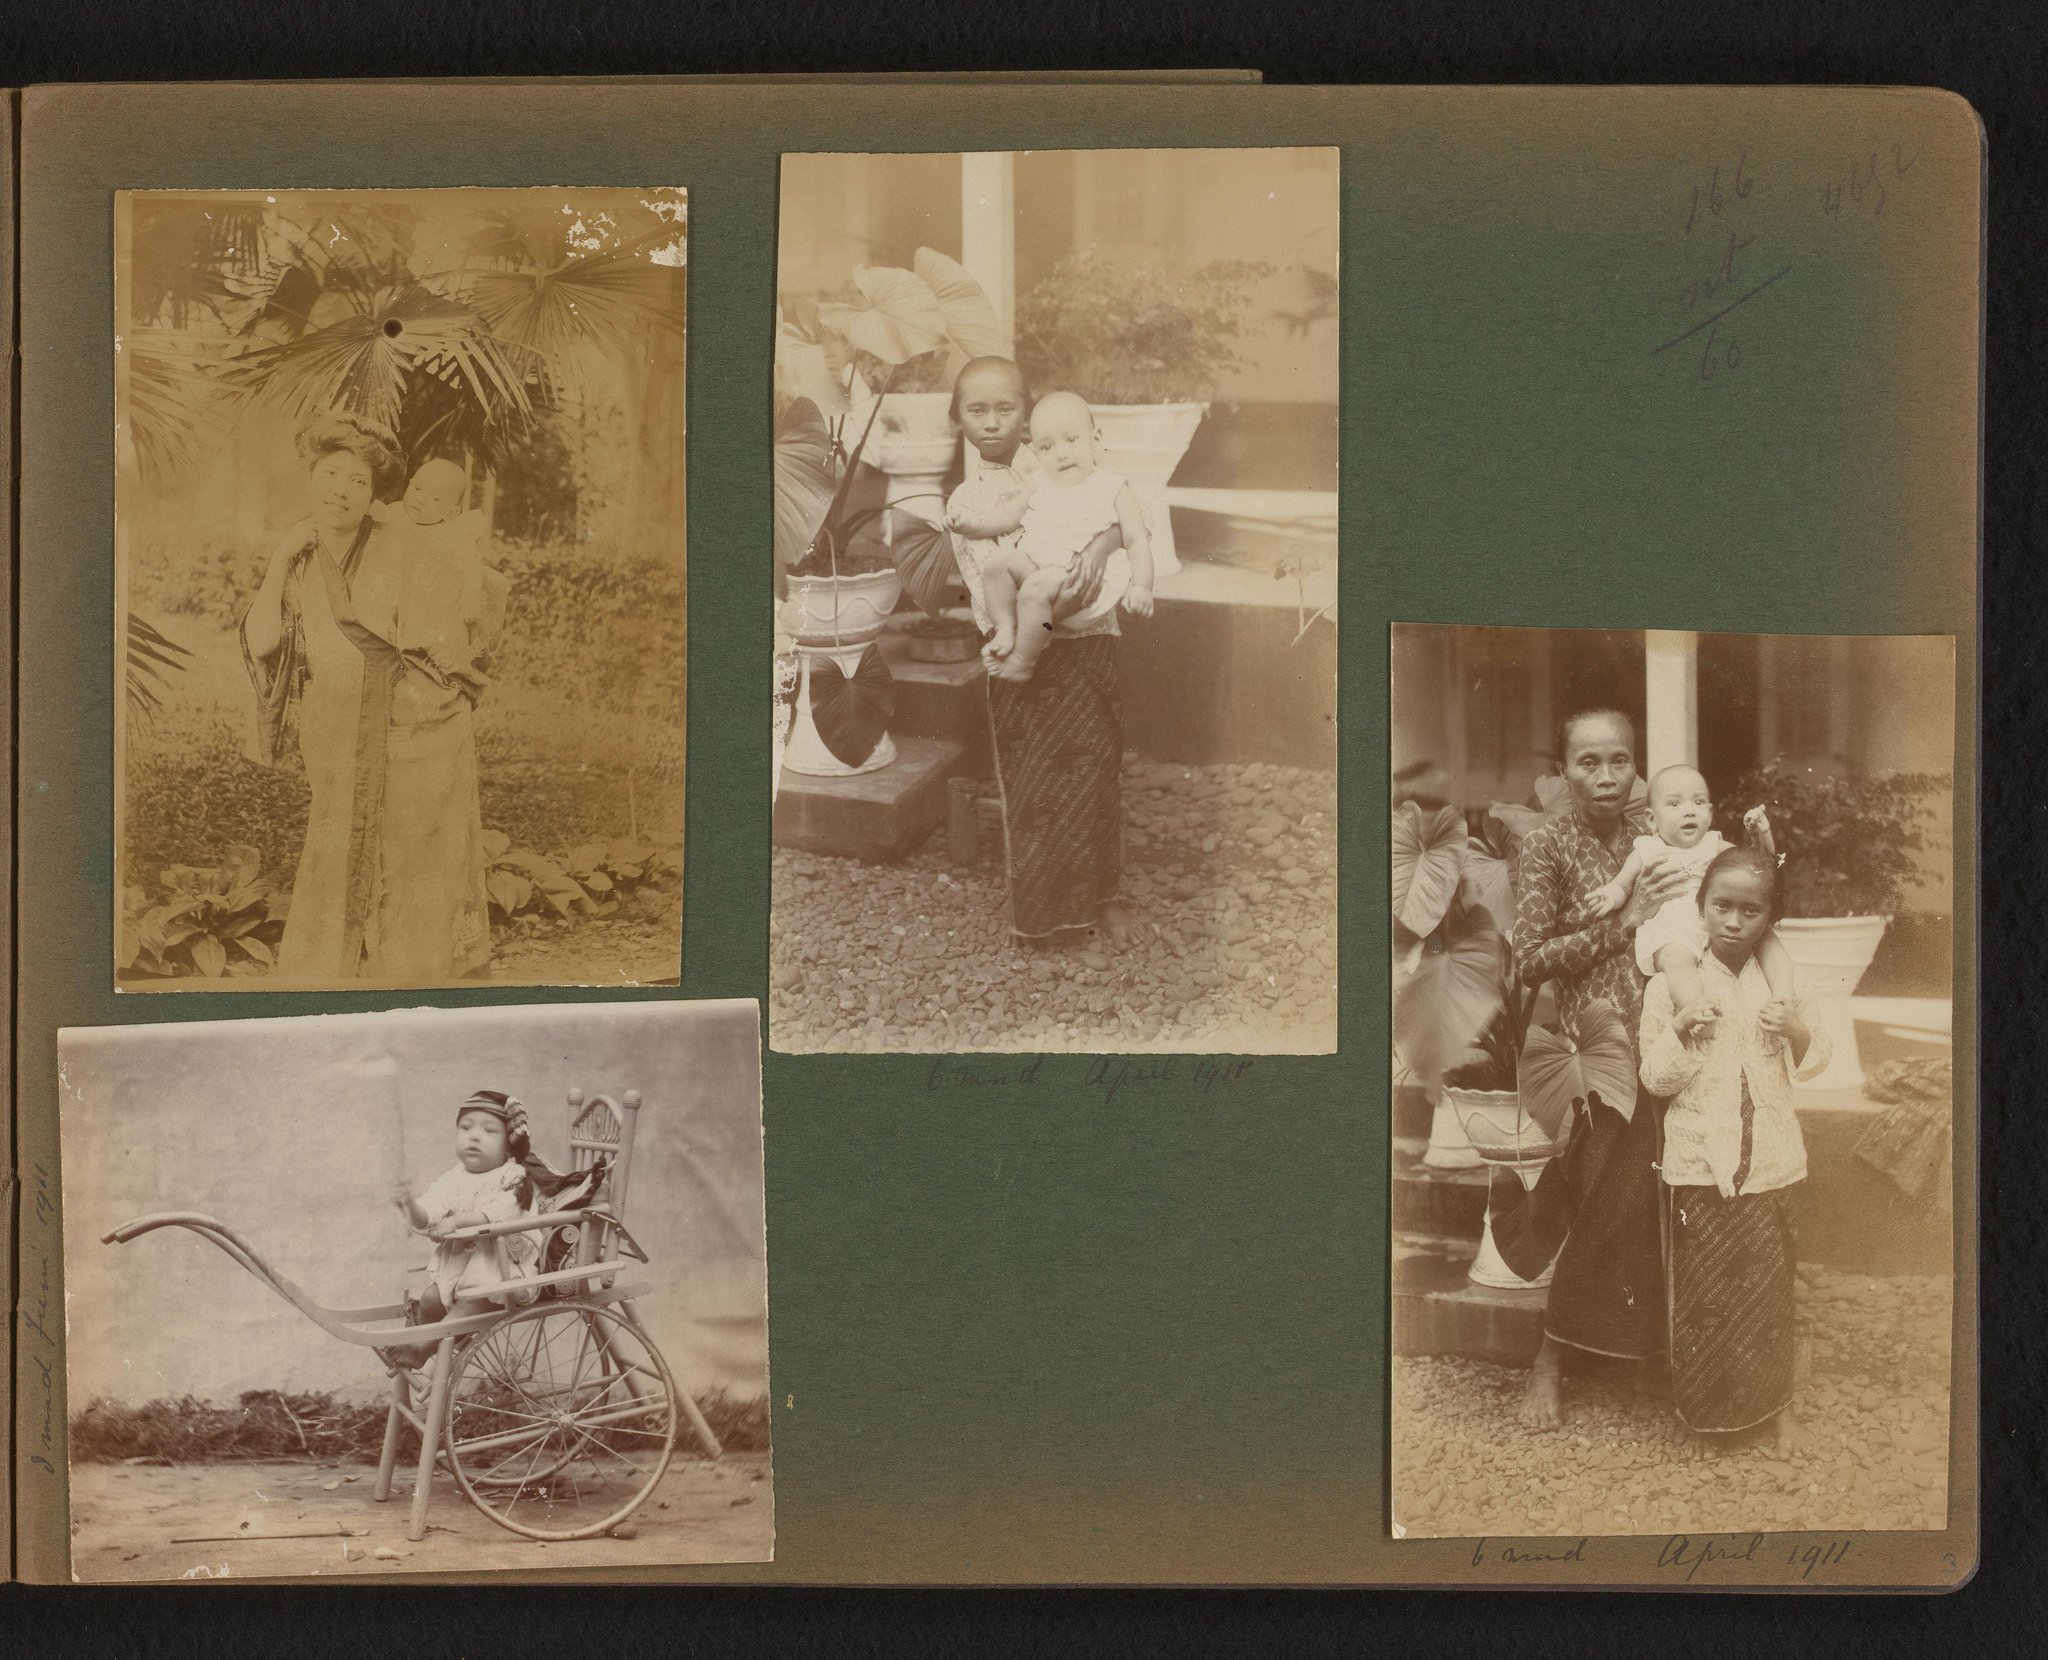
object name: photograph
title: Vier foto's van baby Han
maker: frédéric gabriël dumas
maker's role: engineer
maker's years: 1886-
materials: cardboard, photographic support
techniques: collodion silver print, gelatin silver print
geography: dutch east indies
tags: java, baby-sitter, baby-carriage, pram, perambulator, male infant, family life at home, dutch east indies, the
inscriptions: annotation: ‘3 mnd Juni 1911 / 6 mnd April 1911’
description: Blad met vier foto's van baby Han Dumas met zijn moeder, Indonesisch kindermeisje (destijds 'baboe' genoemd) en zittend in een kinderwagen. Onderdeel van het fotoalbum over de kindertijd van Han (geboren sept-okt 1910) en Eef Dumas (geboren februari 1915) in Indië.